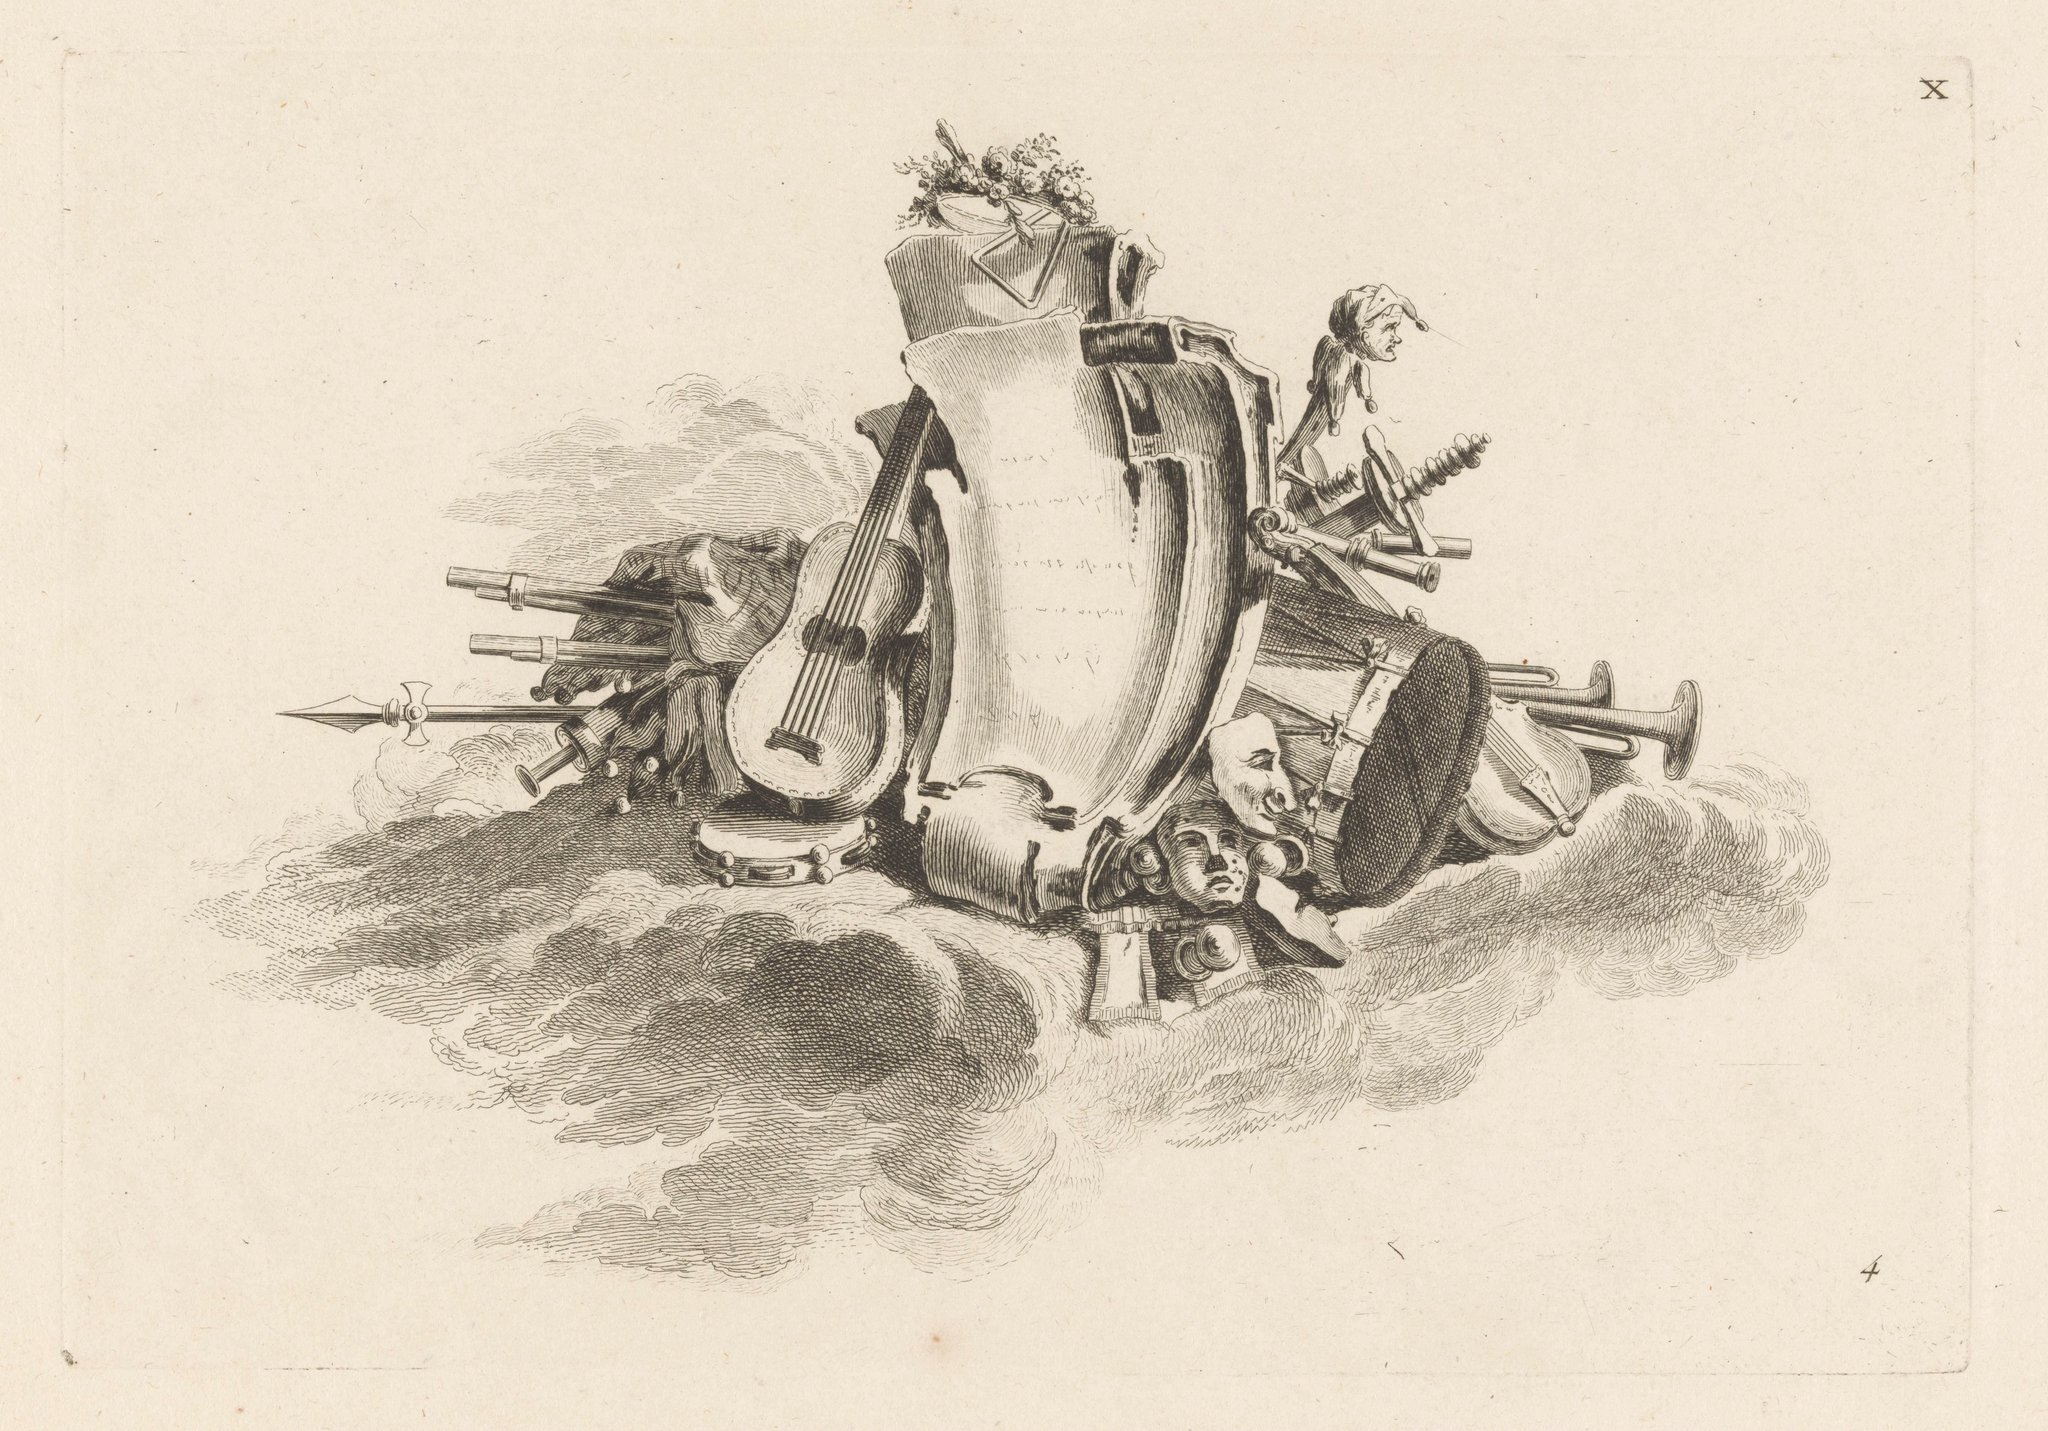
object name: print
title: IIe Volume De l'Oeuvre de J. Ch. Delafosse (...)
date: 1771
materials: paper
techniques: engraving, etching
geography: paris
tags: musical instruments; group of musical instruments, ornament ~ cartouche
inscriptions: collector's mark: Lugt 2760, collector's mark: Lugt 2228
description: Een cartouche omgeven door muziekinstrumenten, maskers en wapens.